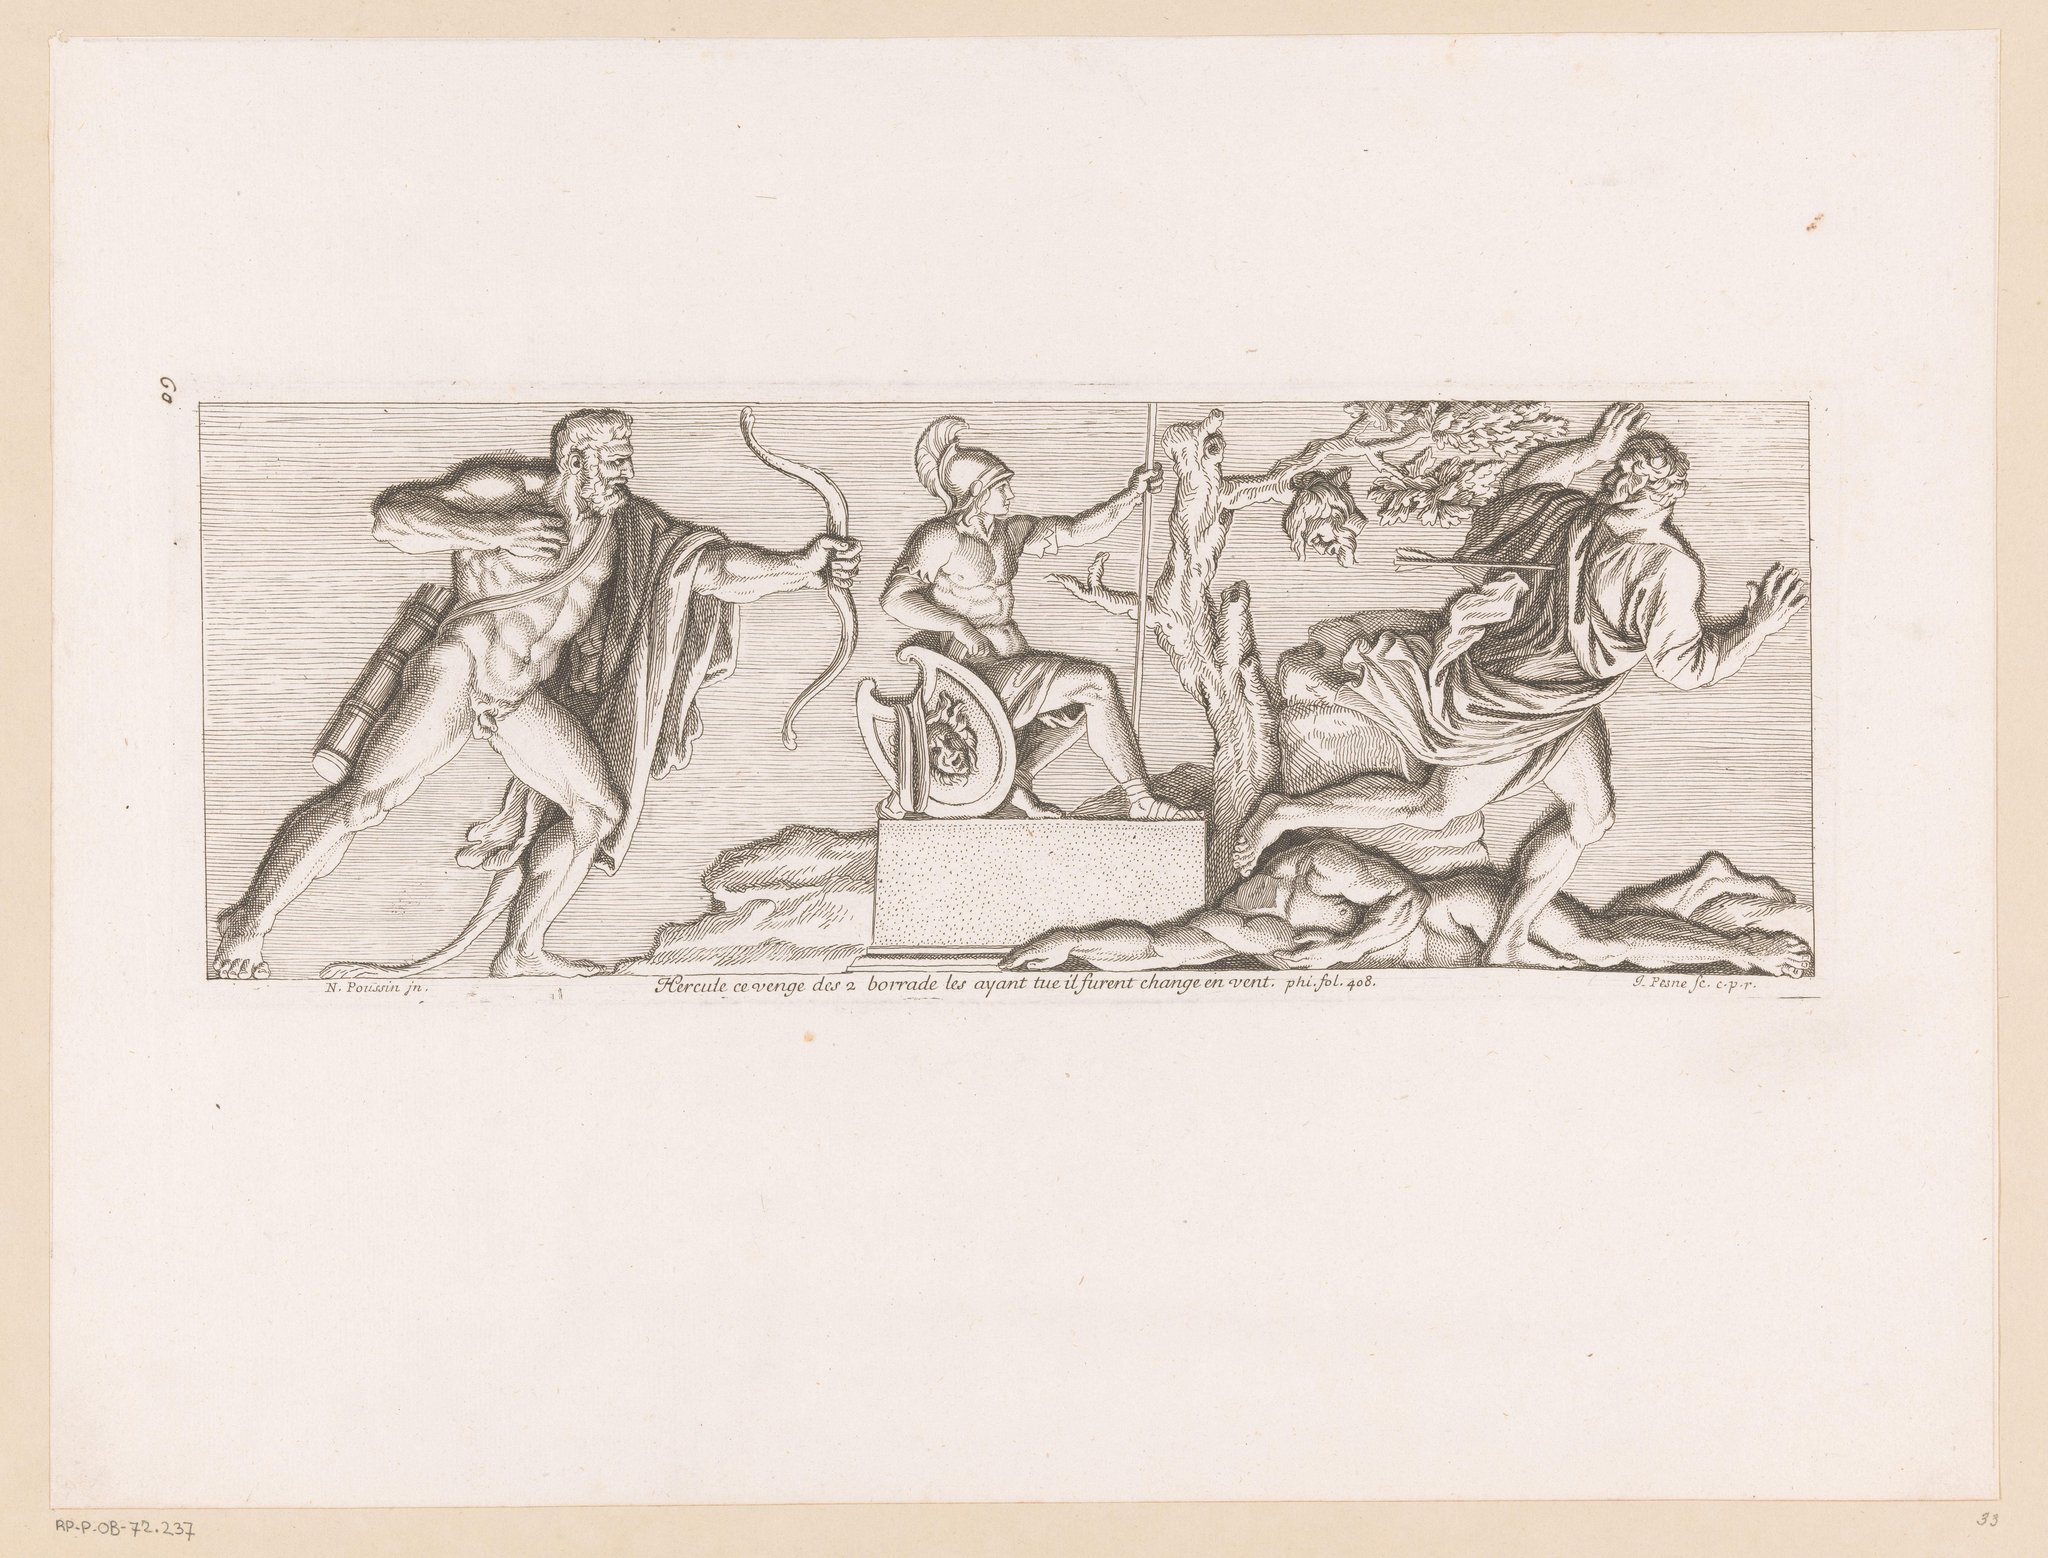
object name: print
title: Hercules wreekt zich op de Boreaden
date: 1678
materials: paper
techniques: engraving, etching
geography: france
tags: (story of) hercules (heracles), calais and zetes, the boreadae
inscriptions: collector's mark: Lugt 240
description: Prent maakt deel uit van een ongenummerde serie van negentien prenten.